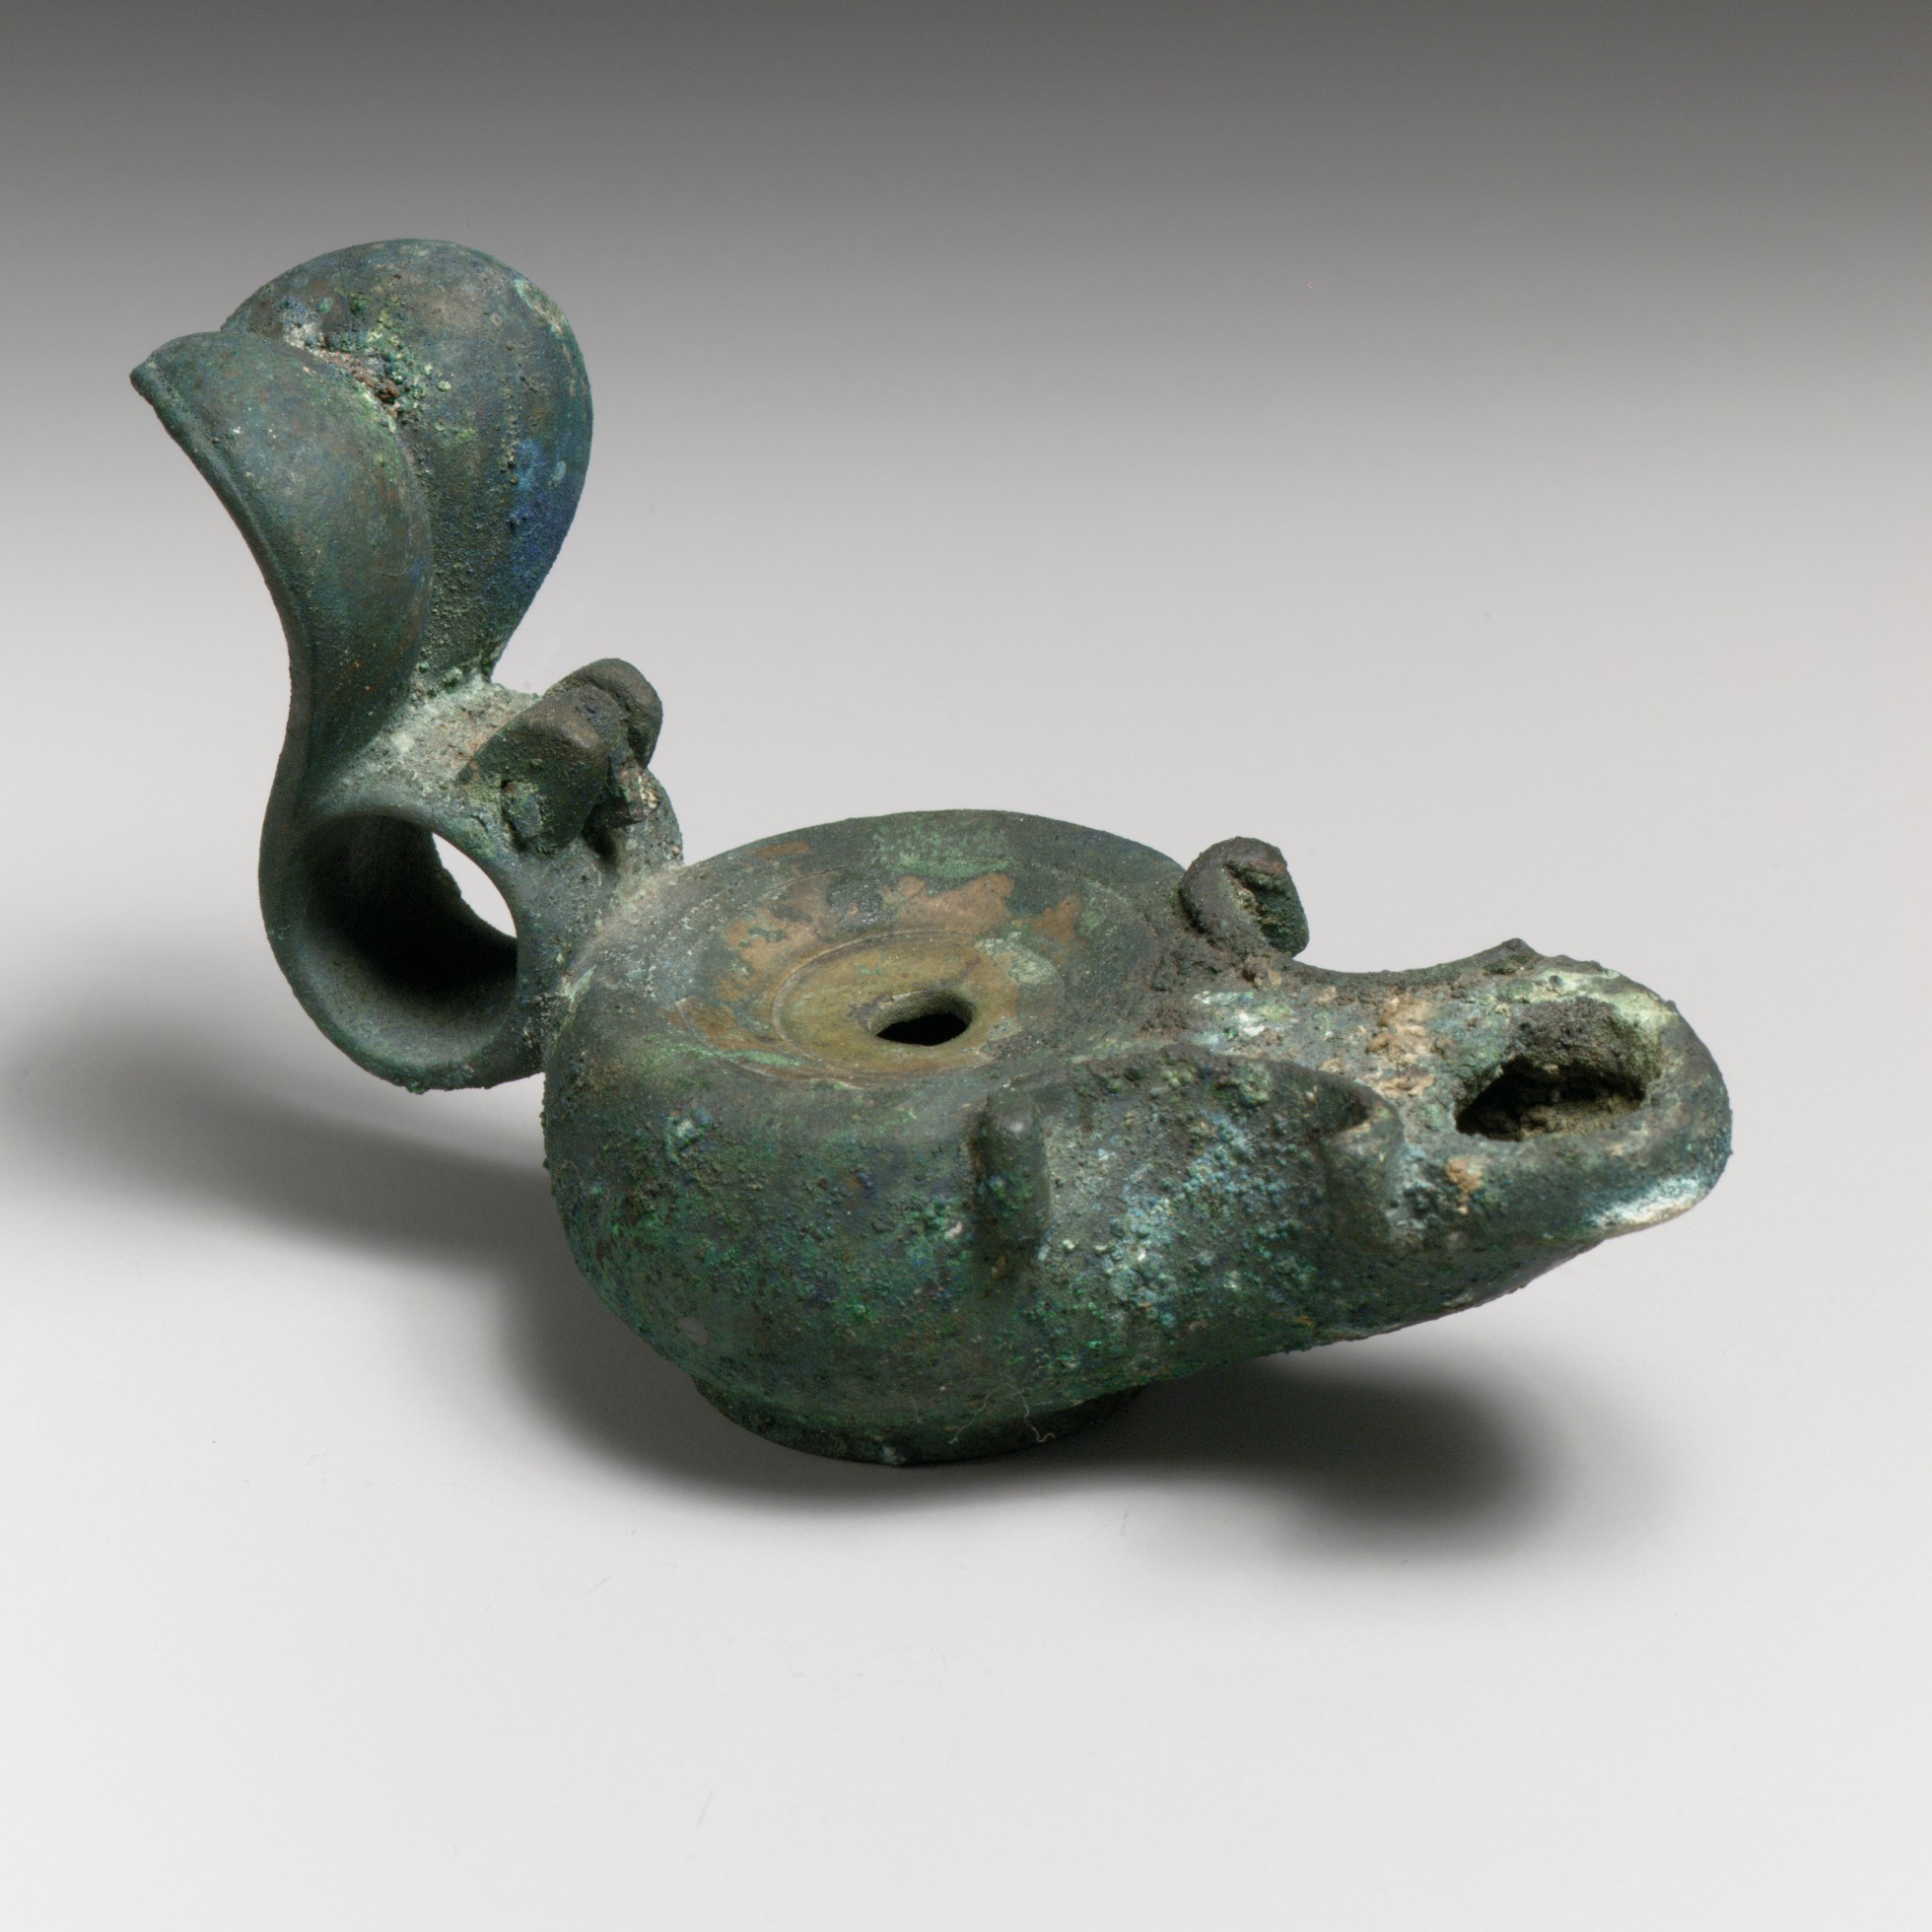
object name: lamp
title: Bronze lamp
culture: roman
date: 1-100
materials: bronze